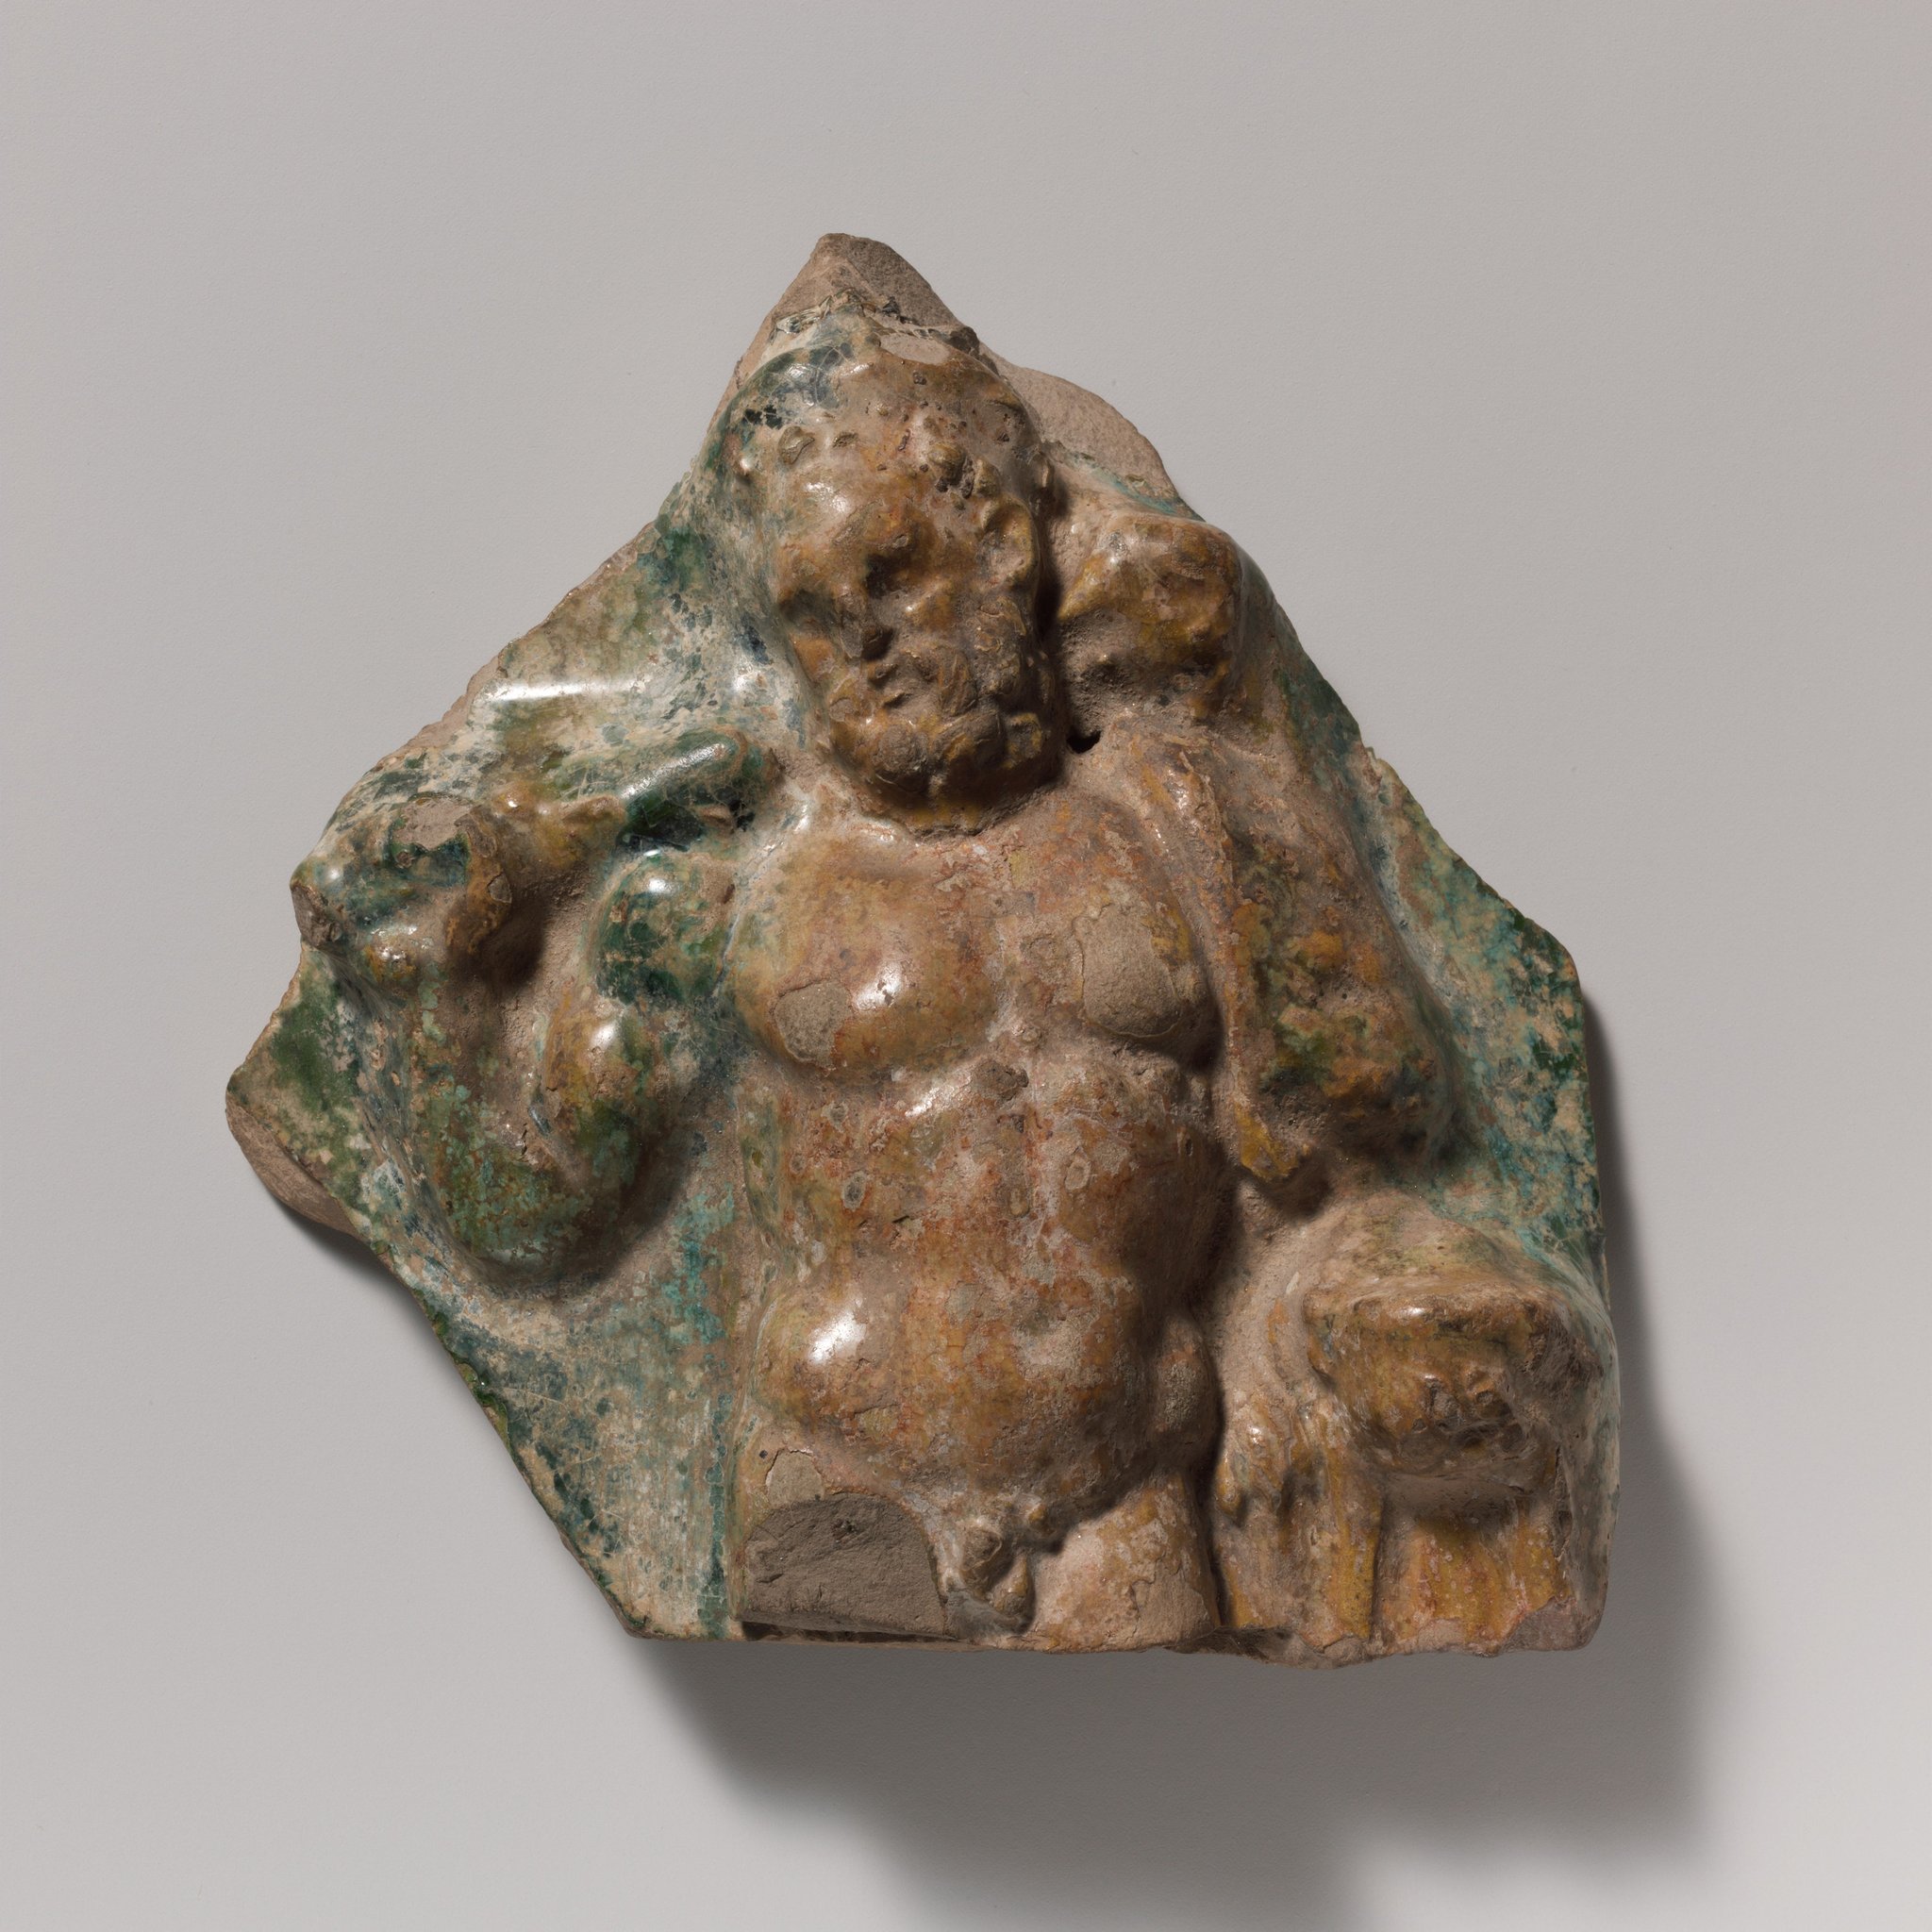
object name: vase fragment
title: Terracotta vase fragment with figure of Hercules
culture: roman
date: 1-200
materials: terracotta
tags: men,hercules